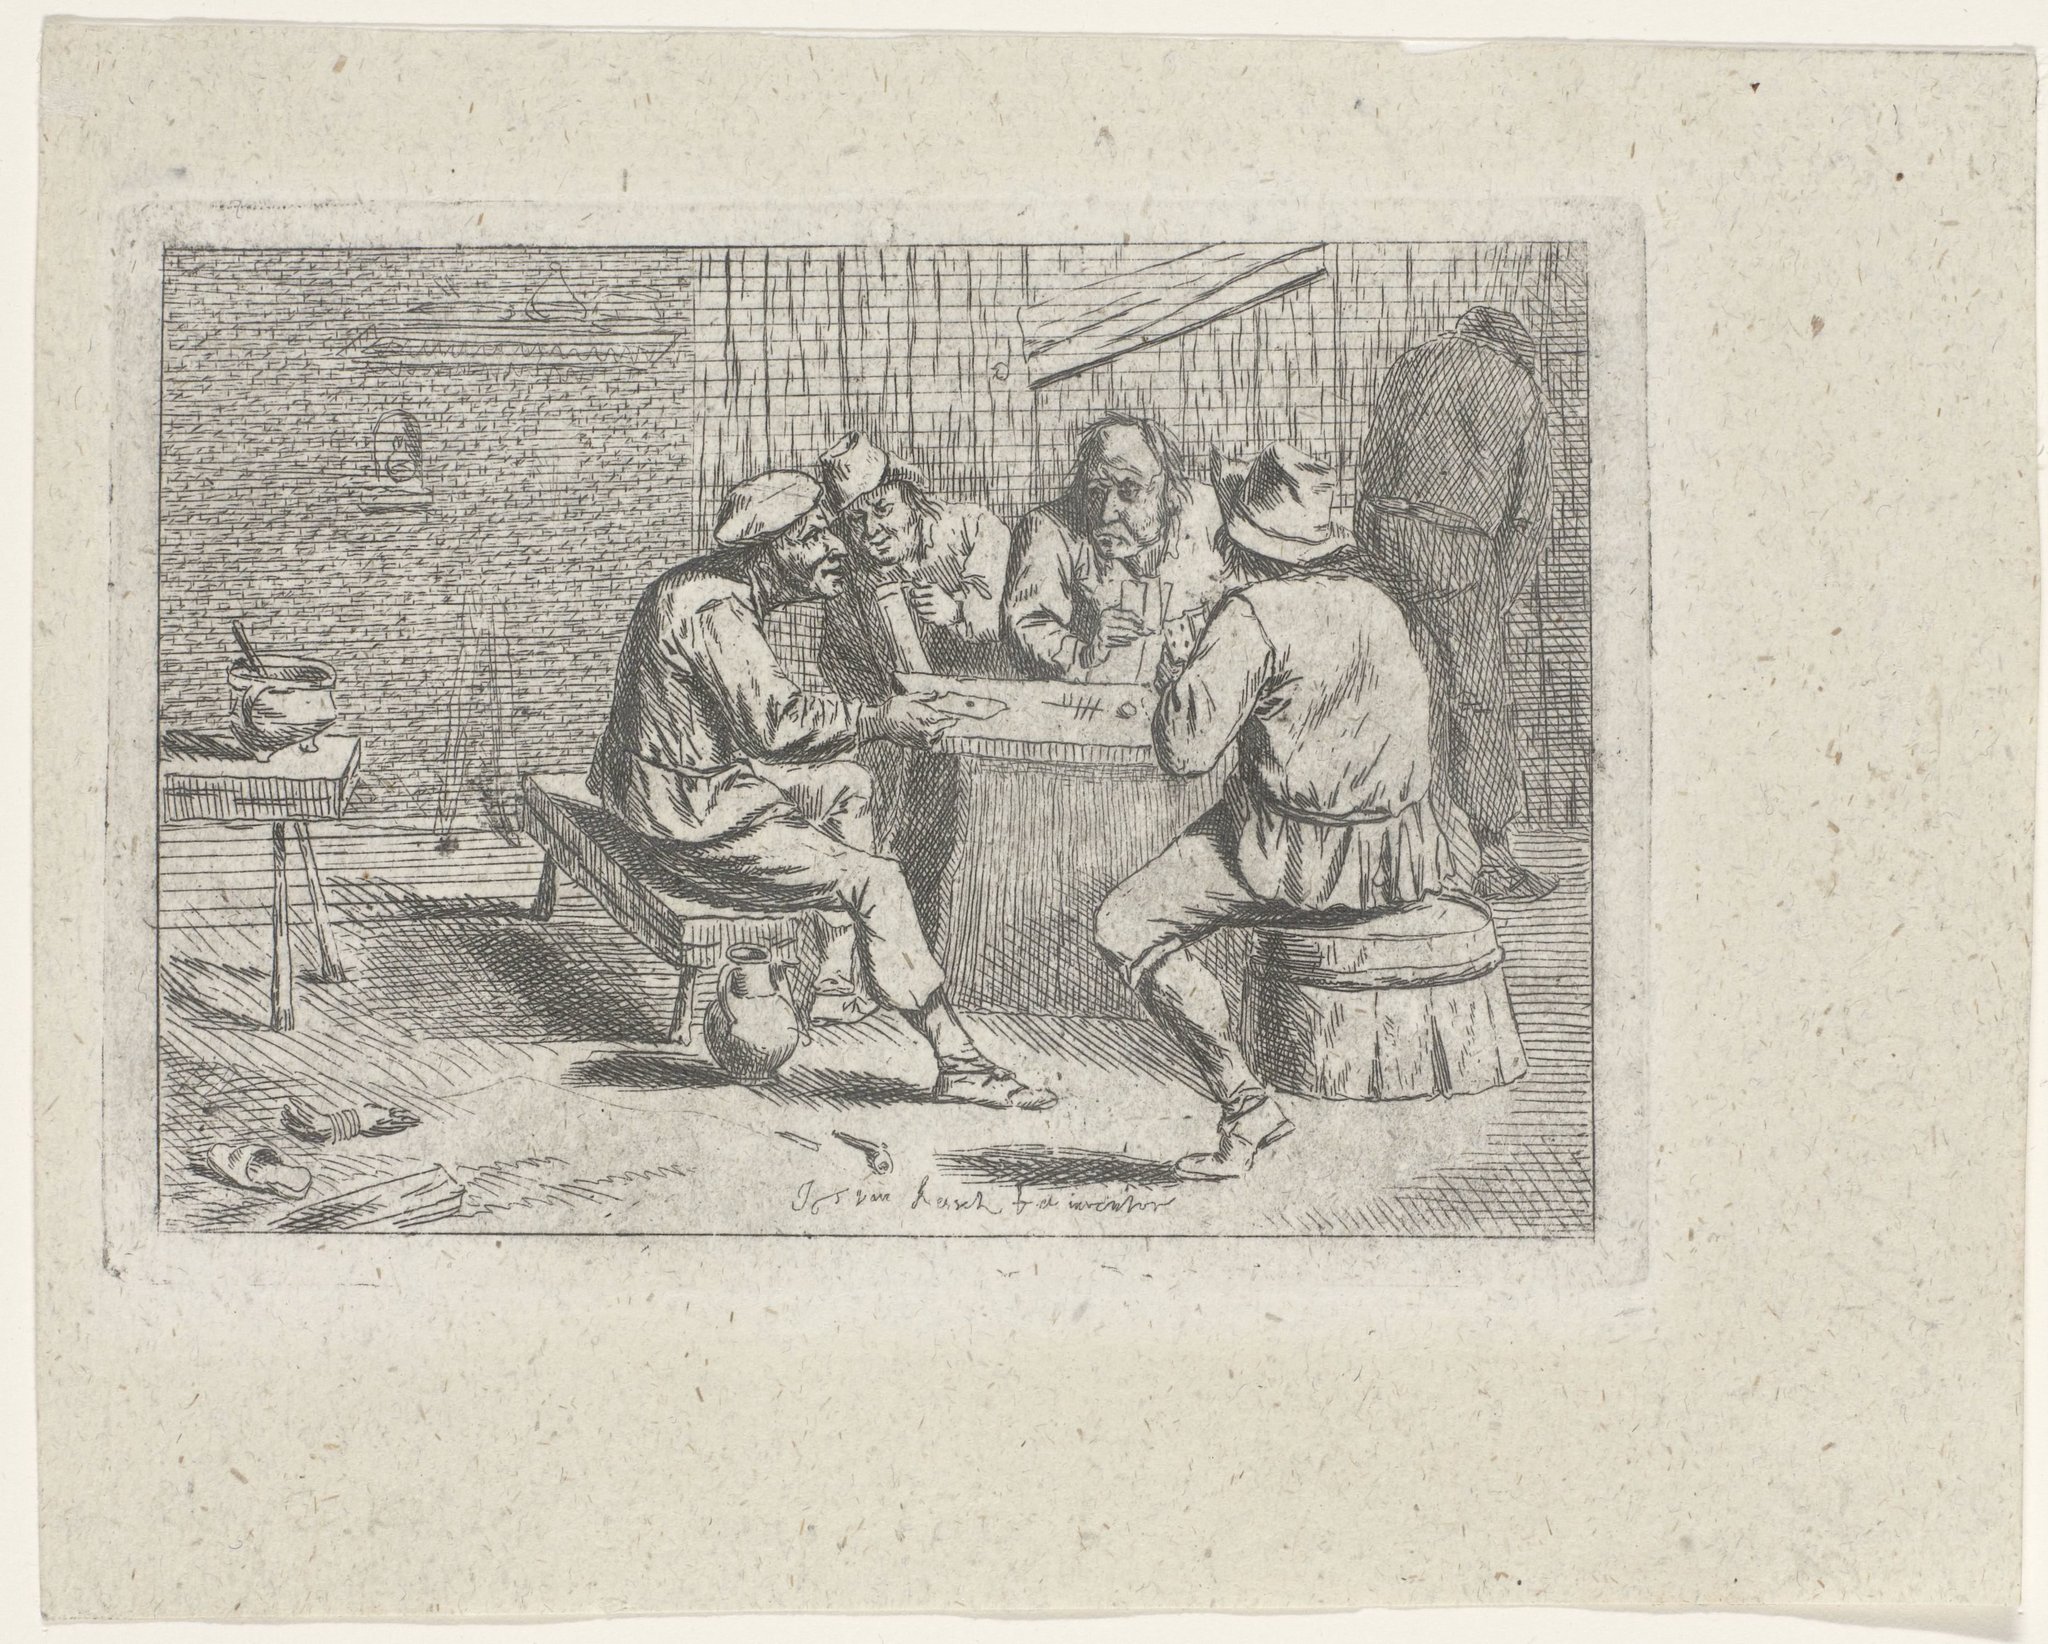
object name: print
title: Herbergscène met kaartspelers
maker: jan thomas van kessel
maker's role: draughtsman, painter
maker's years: 1677-1741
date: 1705-1741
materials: paper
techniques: etching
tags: inn, coffee-house, public house, etc., playing-cards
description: Boerenherberg met vier kaartspelende mannen rond een lage tafel, gezeten op een bank en een omgekeerde ton. In de hoek rechtsachter een man die staat te pissen (?).